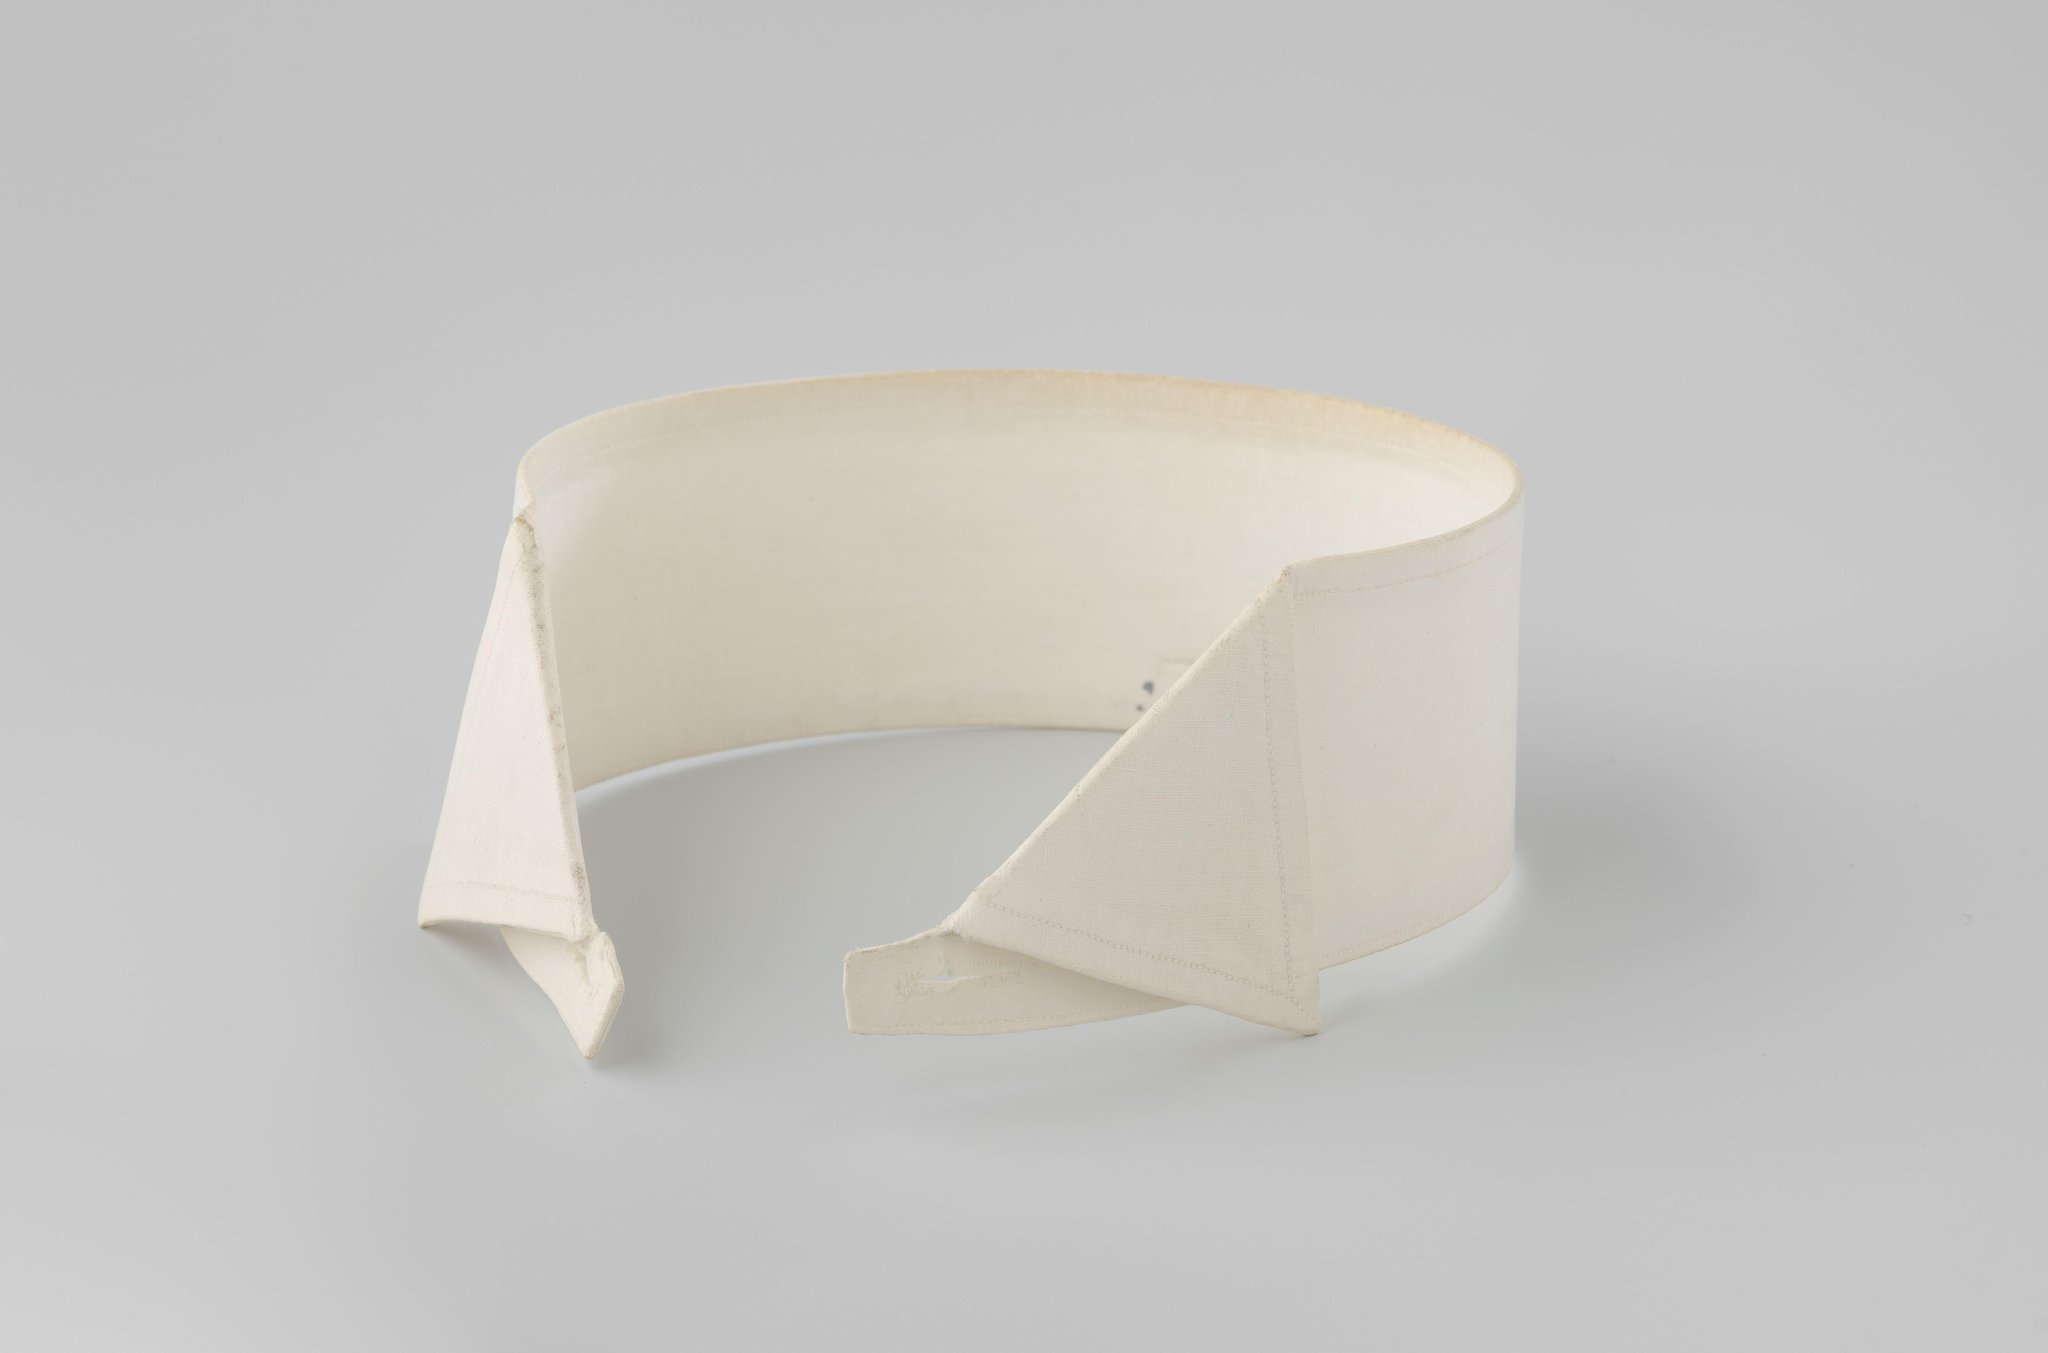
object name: collar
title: Vadermoordenaar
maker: Anonymous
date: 1850-1920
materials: textile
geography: netherlands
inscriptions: inscription: ‘247 GEVERS’